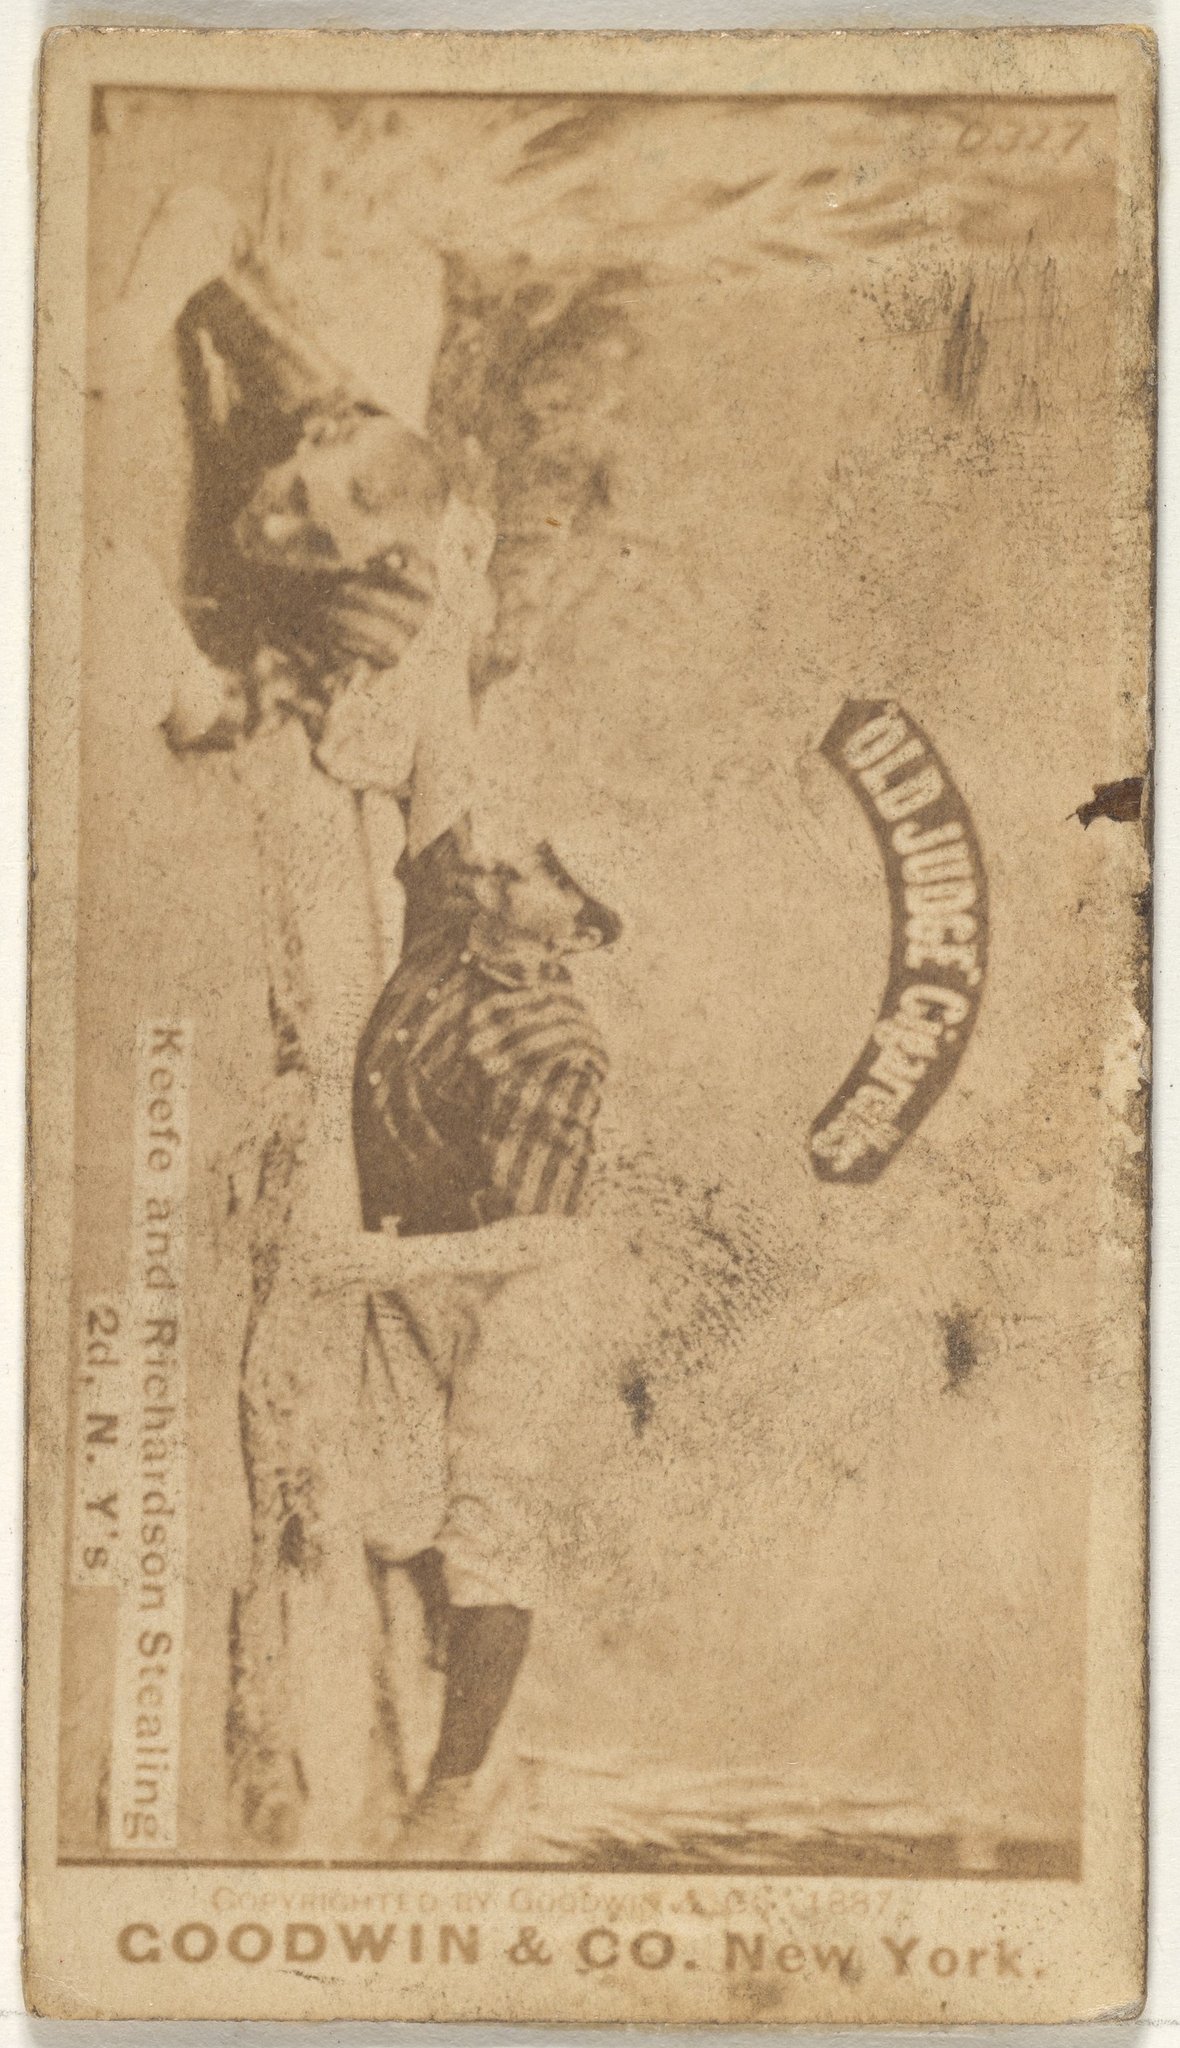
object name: baseball card, photograph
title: Keefe and Richardson Stealing 2nd Base, New York, from the Old Judge series (N172) for Old Judge Cigarettes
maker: goodwin & company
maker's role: publisher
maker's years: 1850-1950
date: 1887-1890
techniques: albumen silver print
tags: men,portraits,baseball,athletes